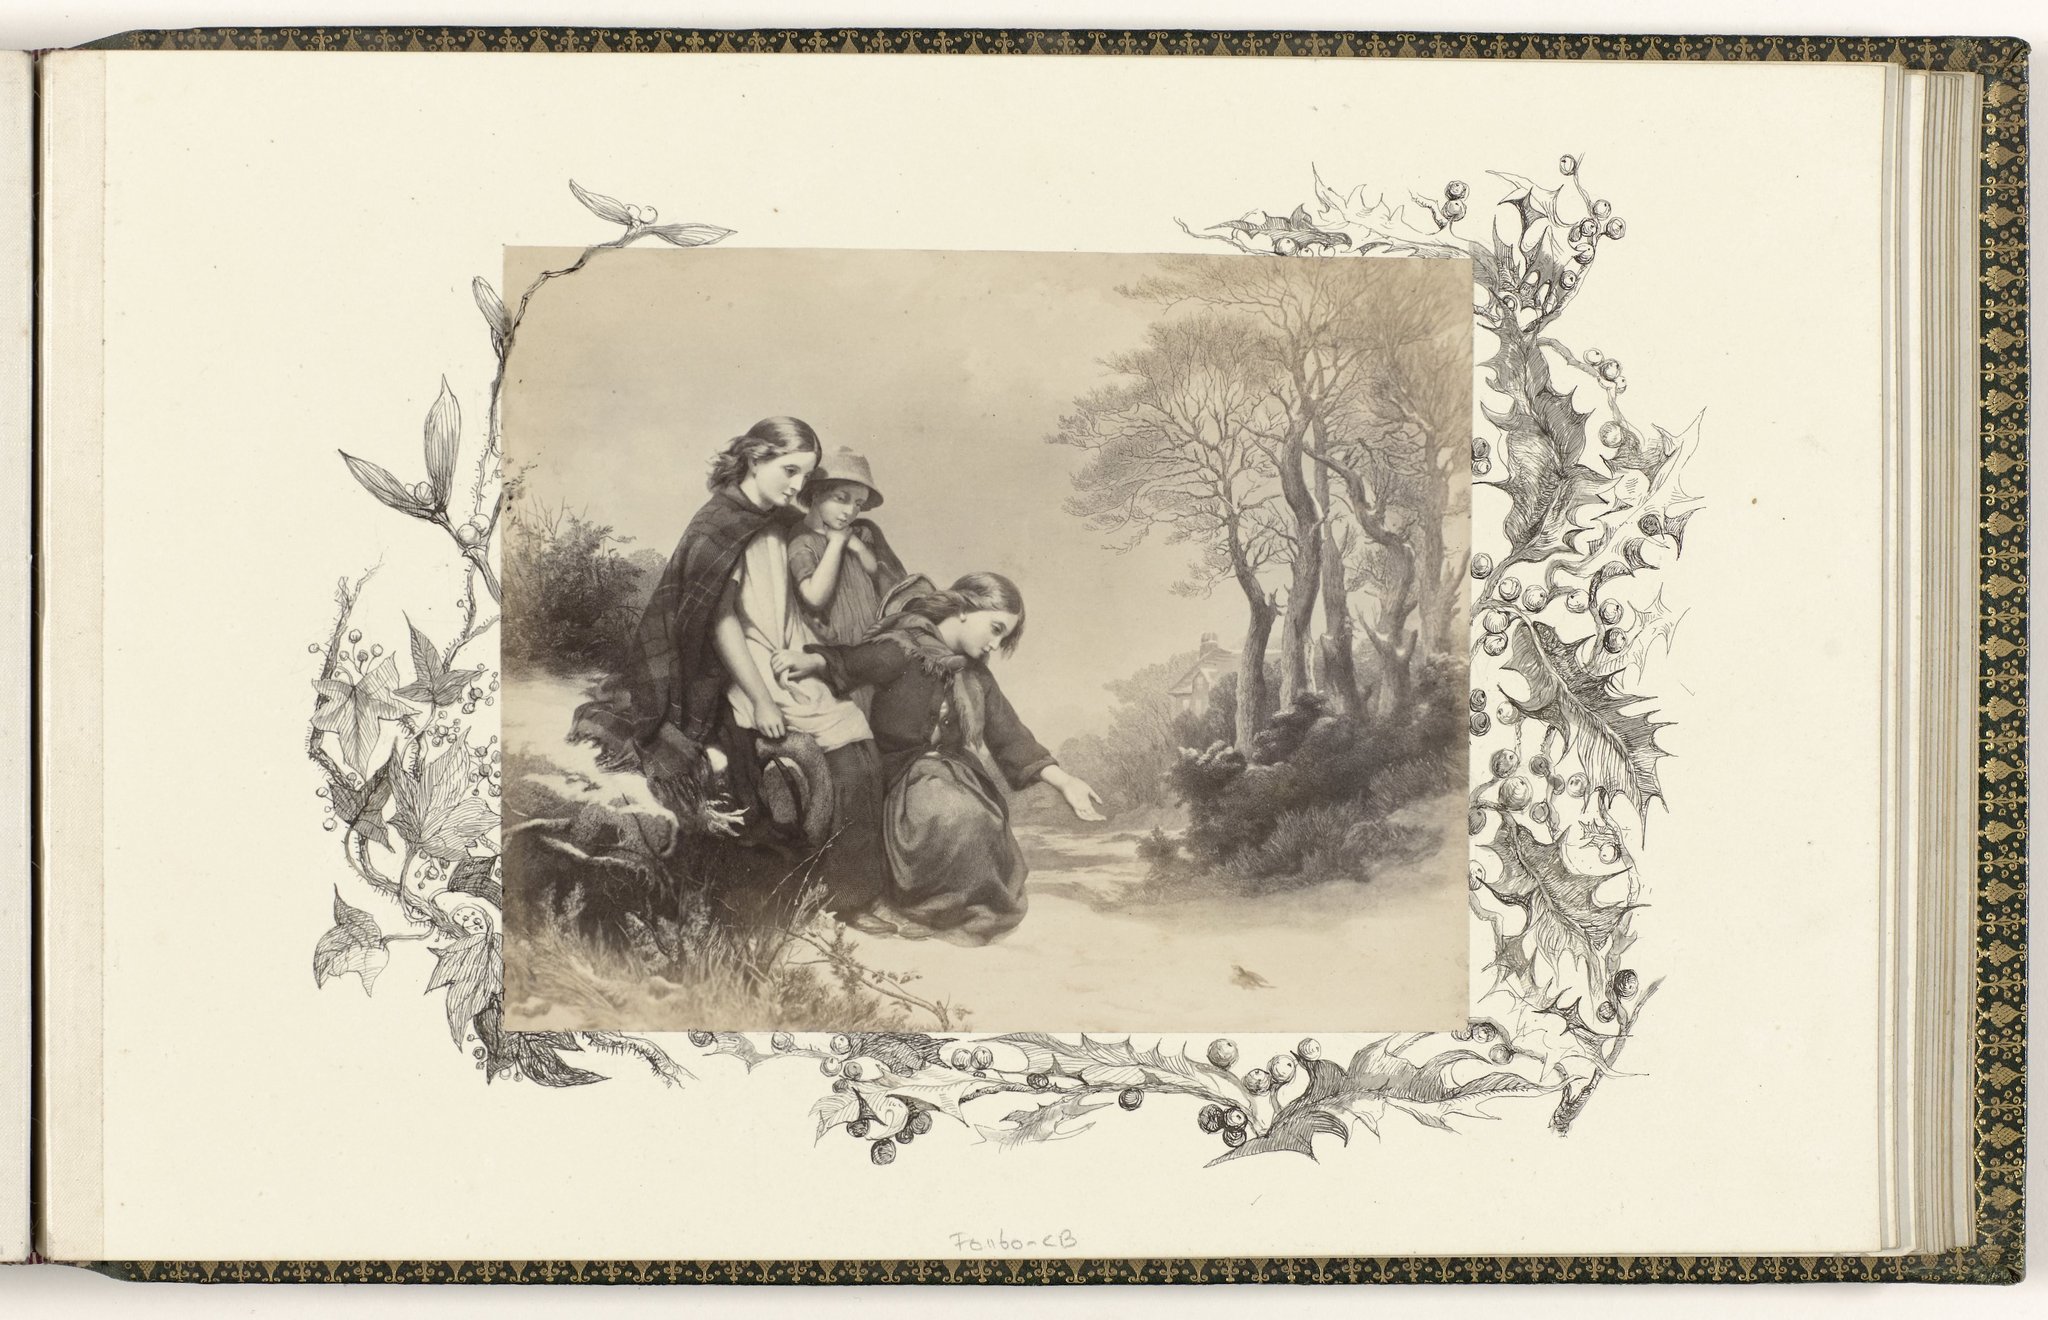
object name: album leaf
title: Fotoreproductie van een gravure voorstellende drie kinderen die een vogel vinden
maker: Anonymous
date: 1870-1880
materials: paper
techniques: albumen print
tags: print, e.g.: engraving, etching, lithograph, child (+ three persons)